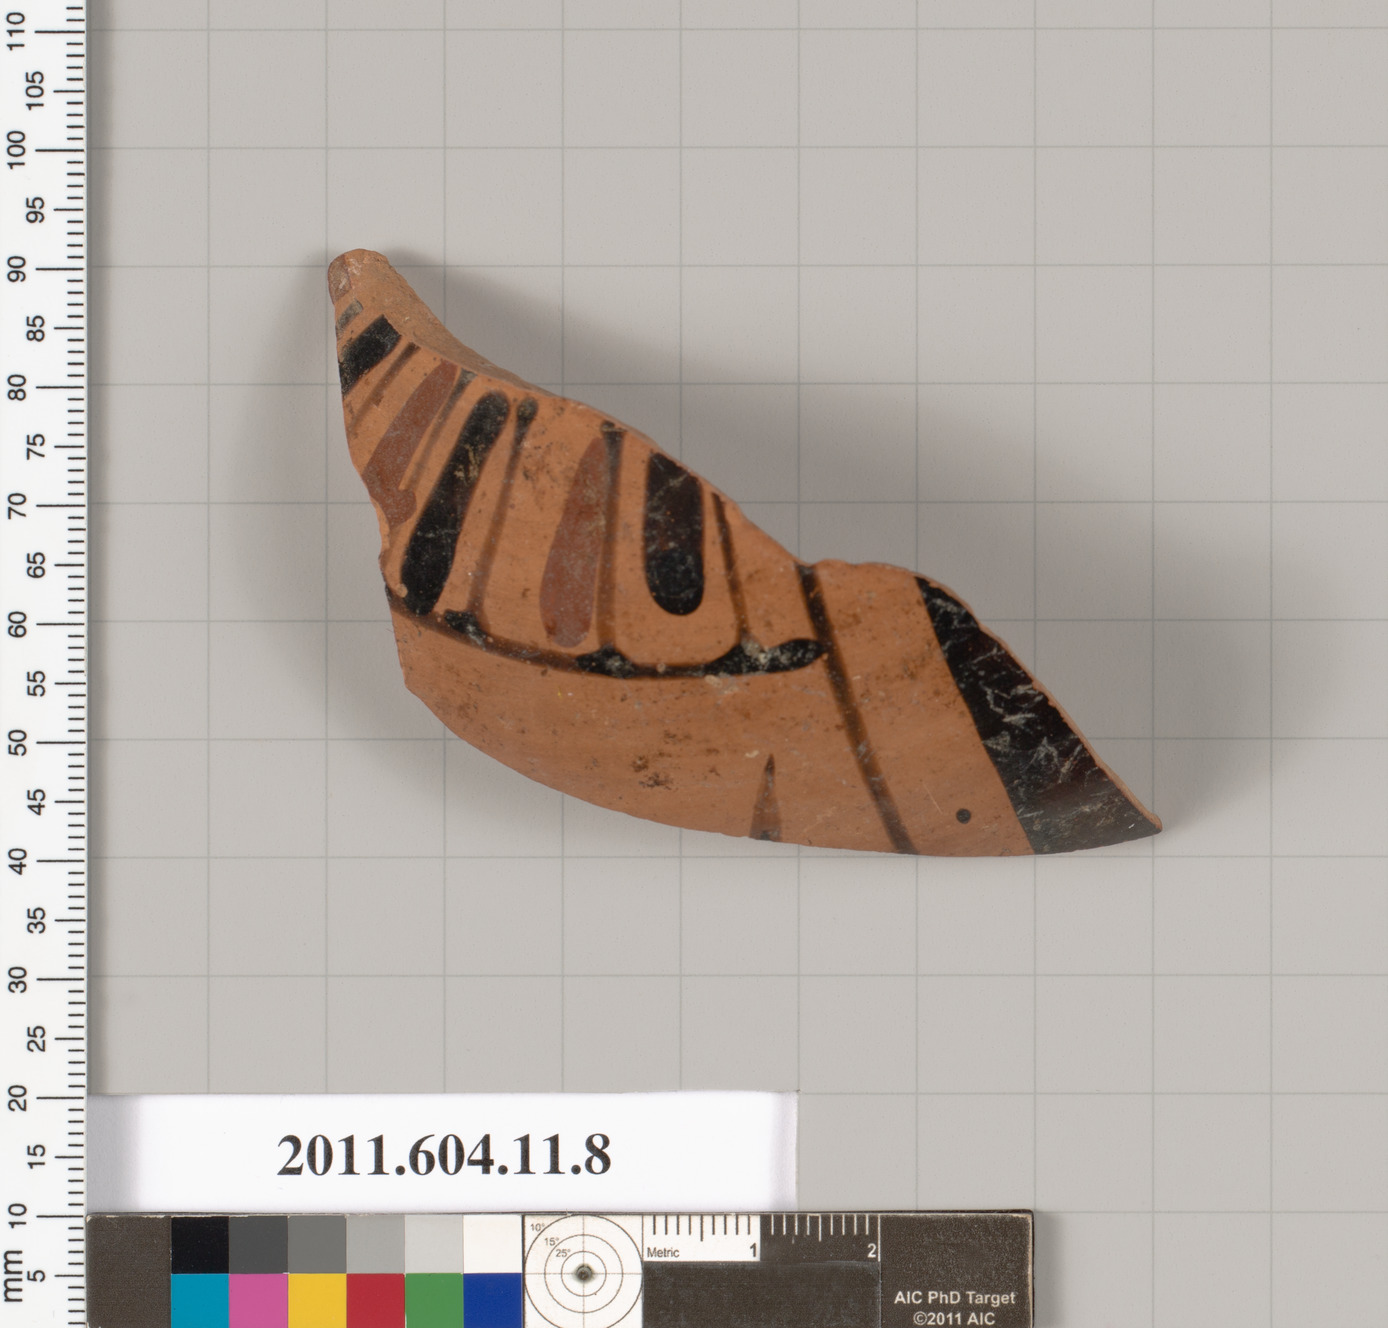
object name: amphora fragment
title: Terracotta fragment of an amphora (jar)?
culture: greek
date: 567-535 BCE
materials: terracotta